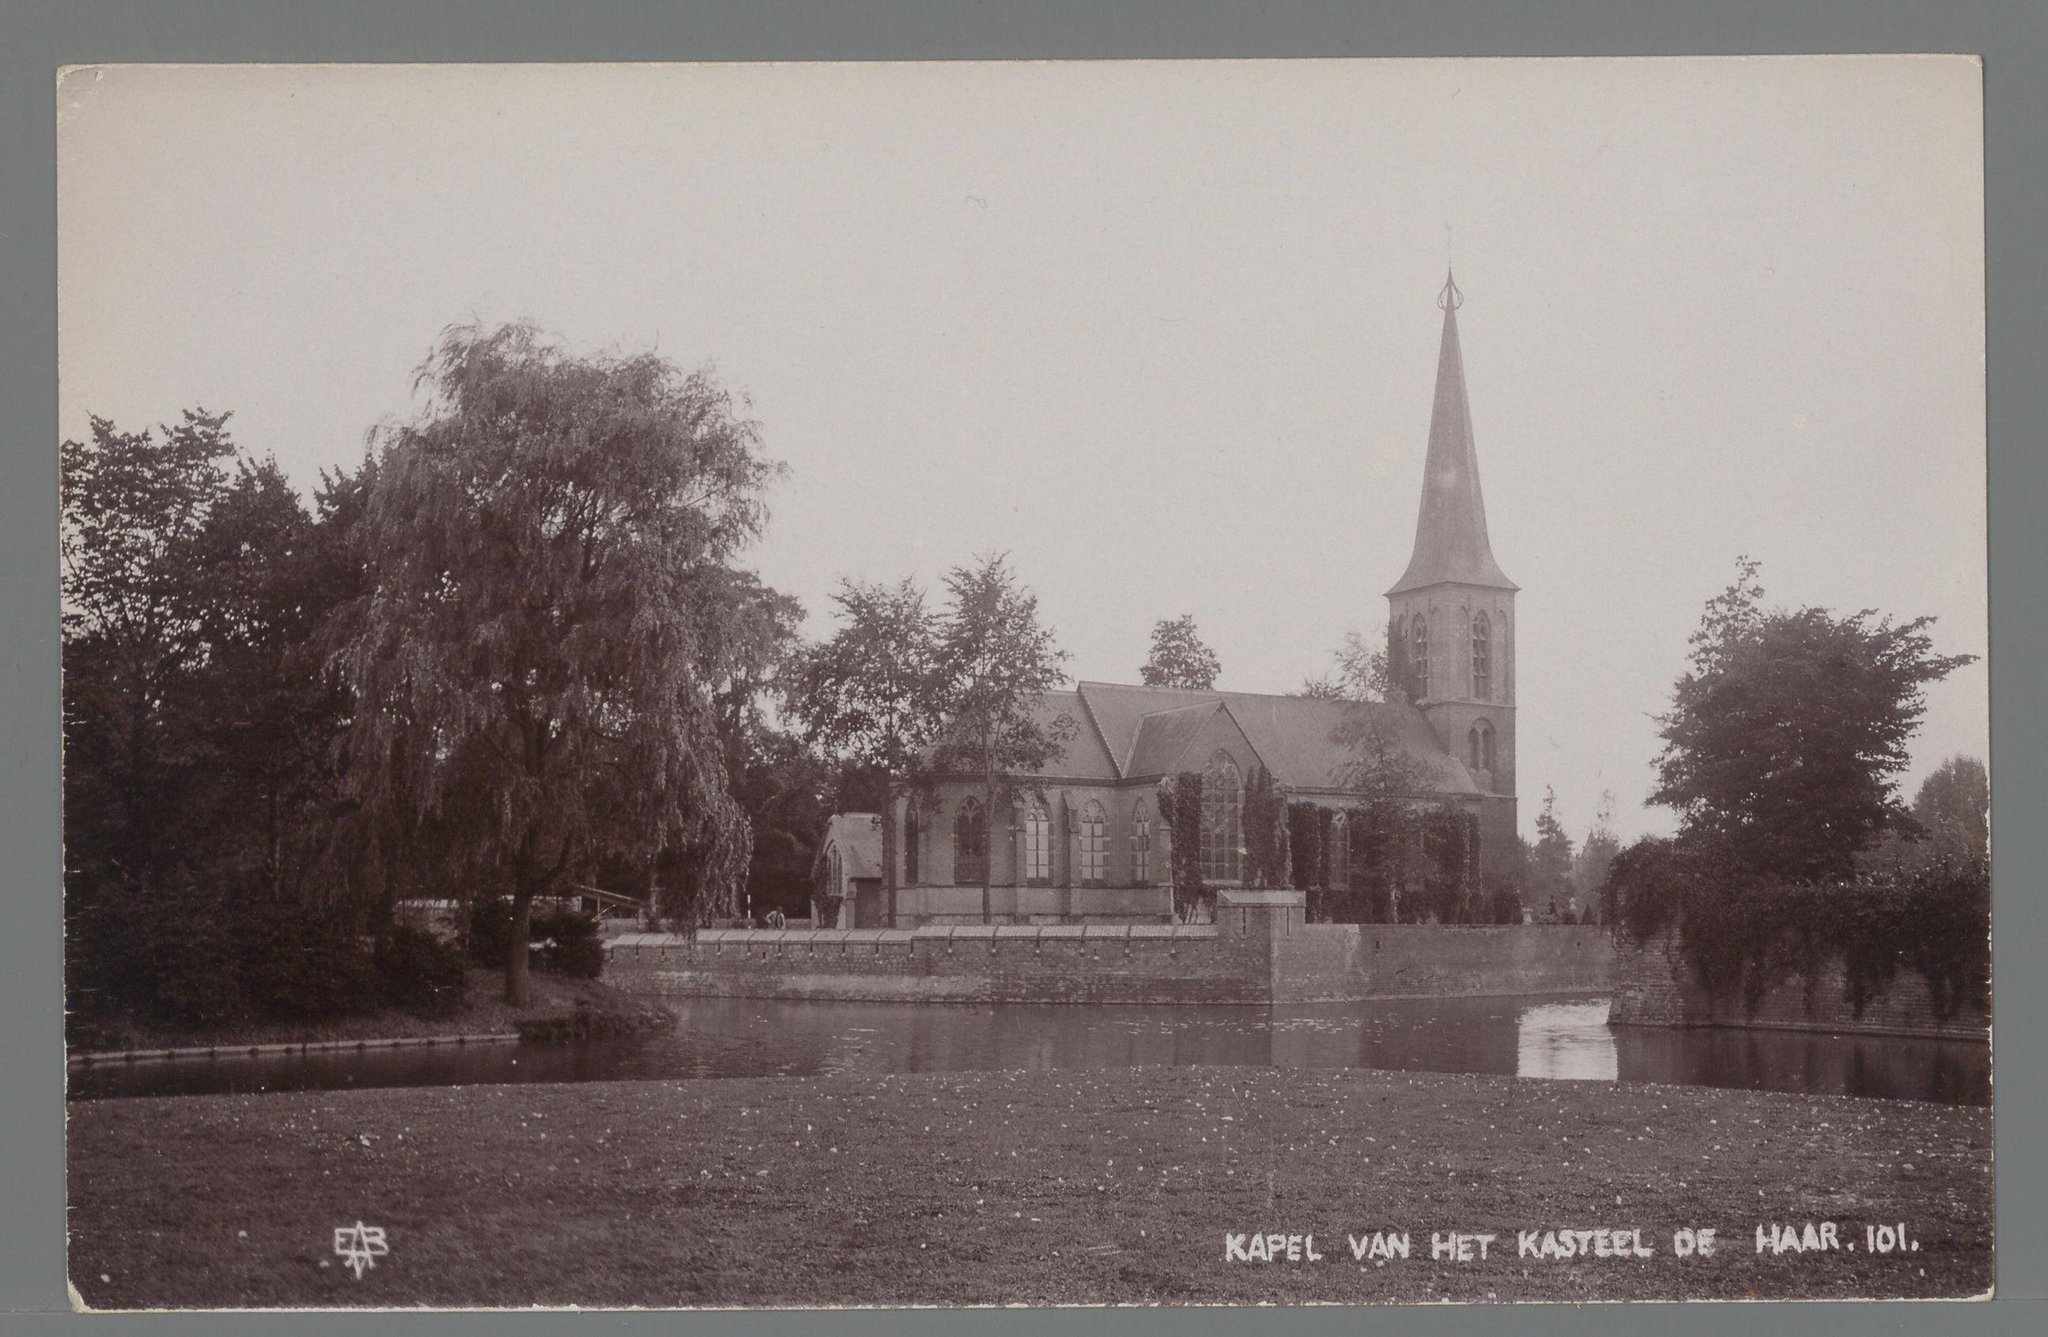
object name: photograph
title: Kapel van het Kasteel de Haar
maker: Anonymous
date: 1900-1930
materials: paper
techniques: collodion silver print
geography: haarzuilens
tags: castle, church (exterior)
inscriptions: monogram: ‘EBvA’